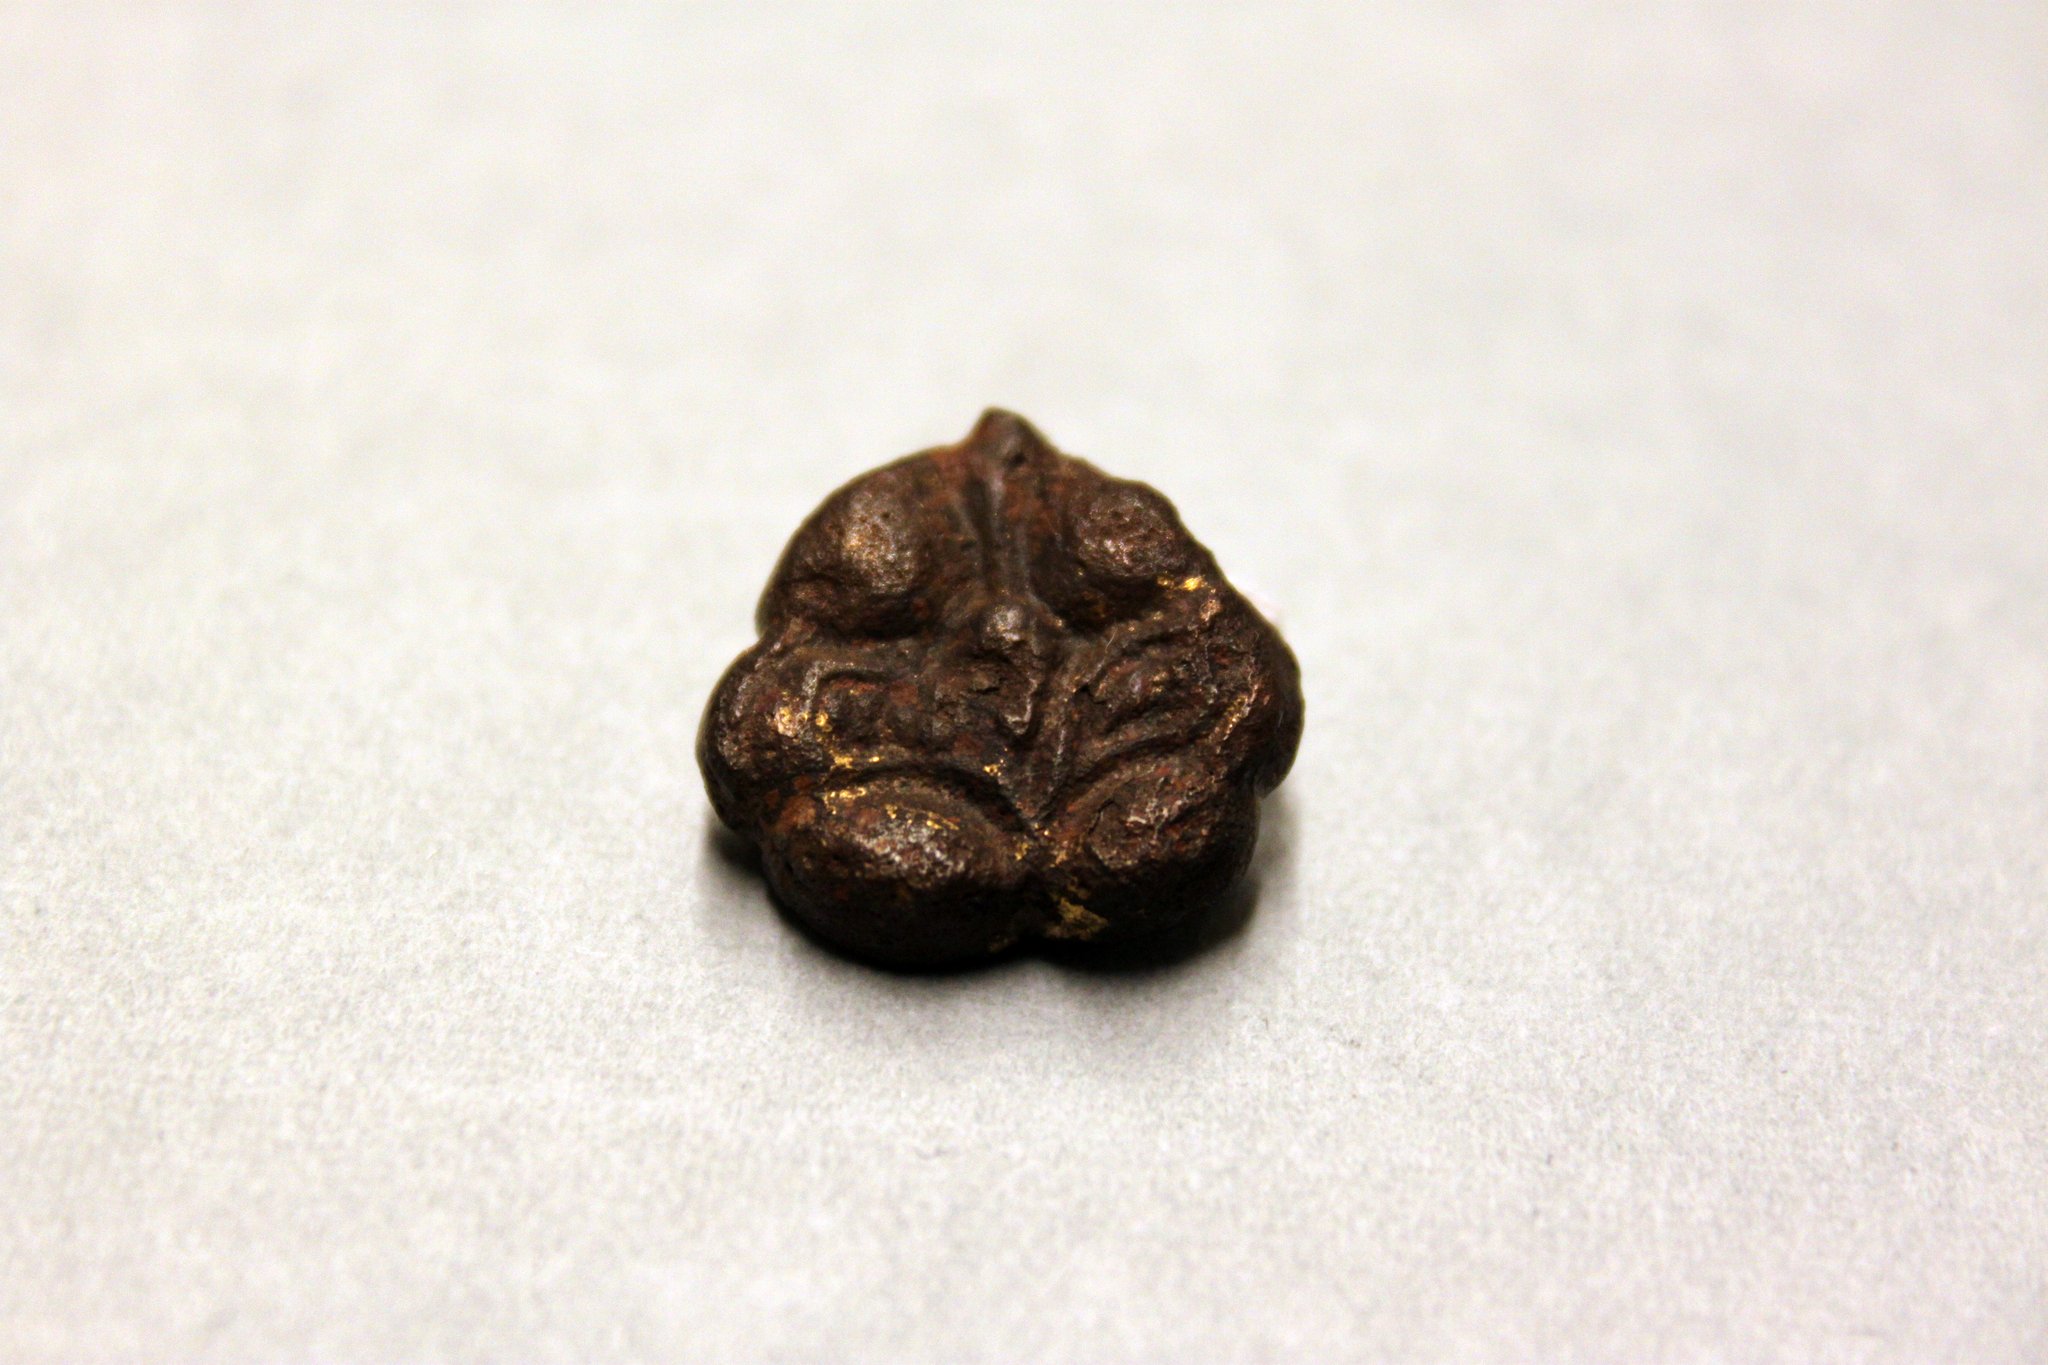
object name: belt fitting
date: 801-1000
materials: bronze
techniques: casting, gilding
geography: iran